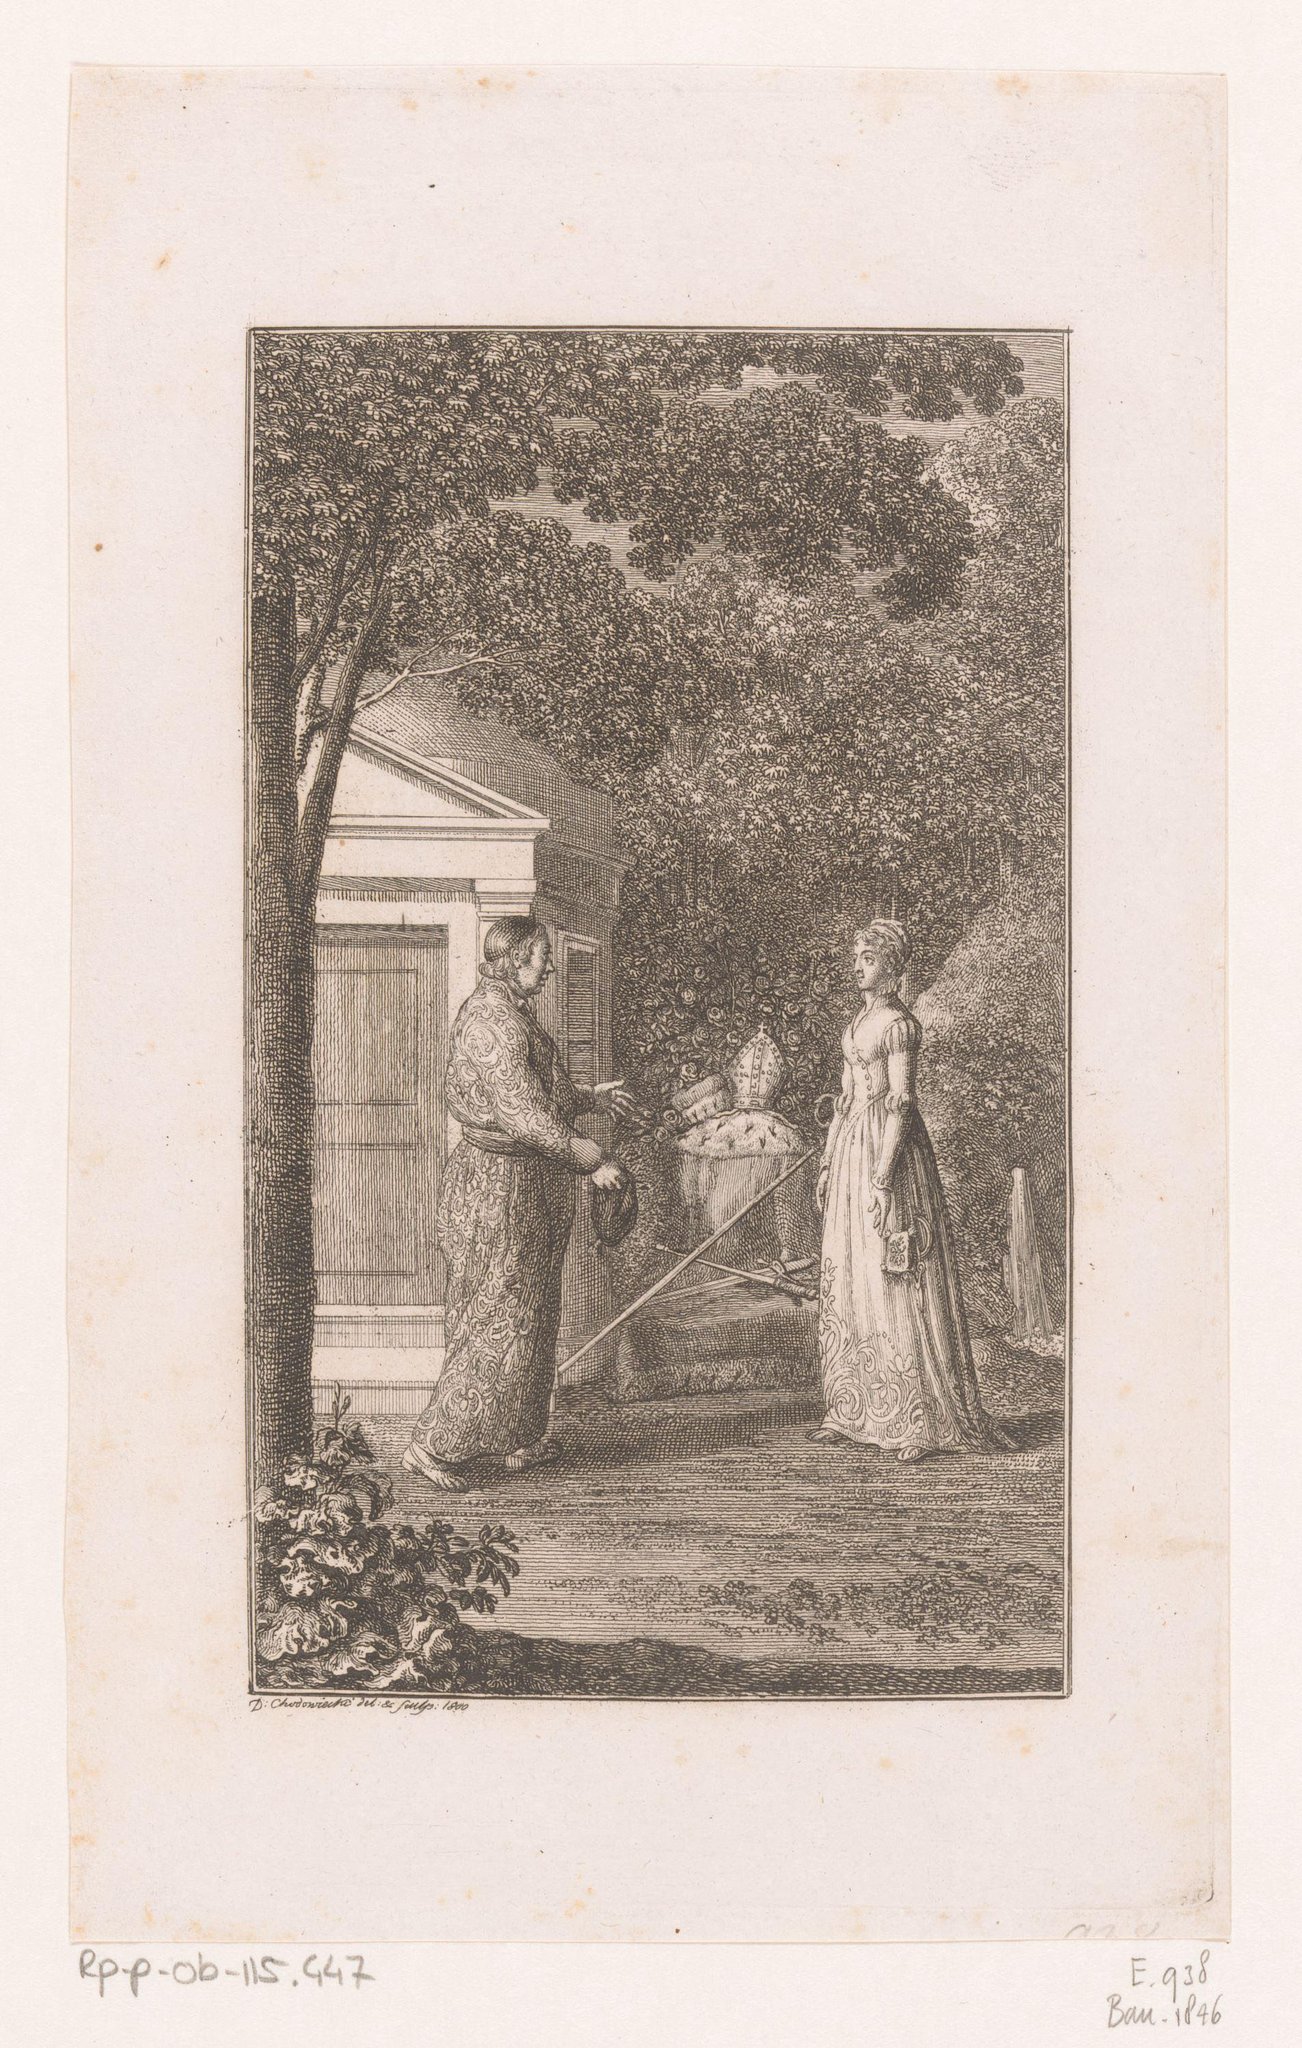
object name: print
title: Gebhard ontmoet Agnes van Mansfeld in de tuin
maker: daniel nikolaus chodowiecki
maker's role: draughtsman, print maker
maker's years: 1726-1801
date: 1800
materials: paper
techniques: etching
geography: berlin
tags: history, insignia of bishop, e.g. mitre, crozier, lovers' meeting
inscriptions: collector's mark: Lugt 2228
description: In de begroeiing achter het stel ligt Gebhards bisschoppelijke kledij en wapentuig als teken van het afstoten van zijn titel als keurvorst en bisschopszetel.